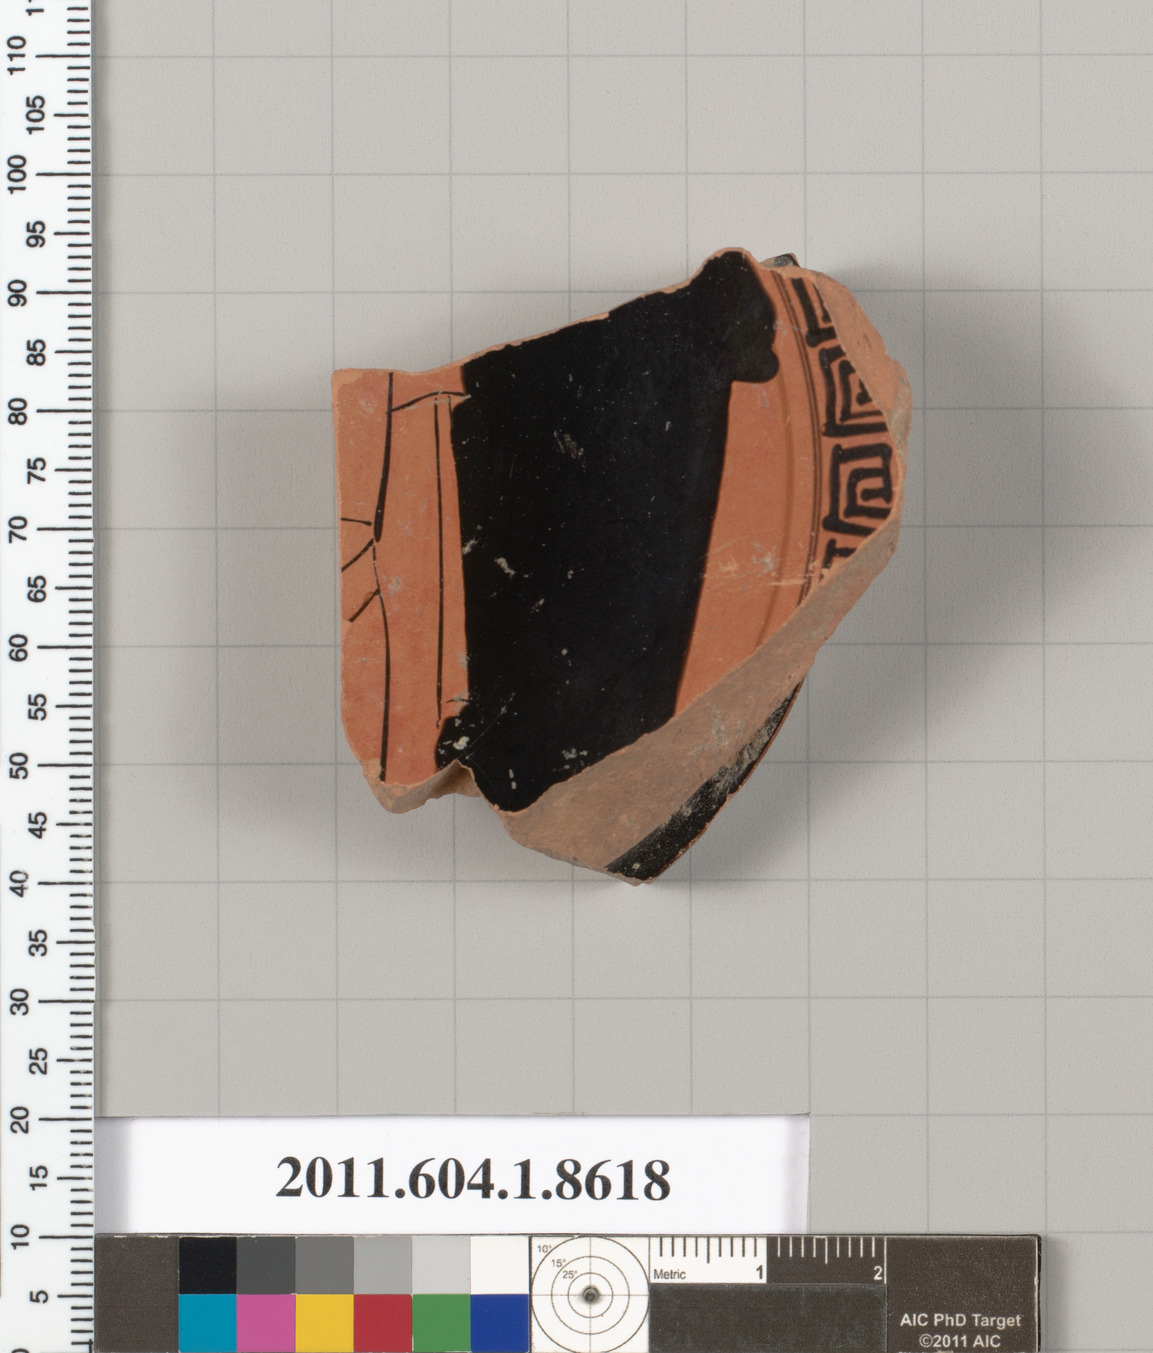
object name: kylix fragment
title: Terracotta fragment of a stemless kylix (drinking cup)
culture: greek, attic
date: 460-450 BCE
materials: terracotta